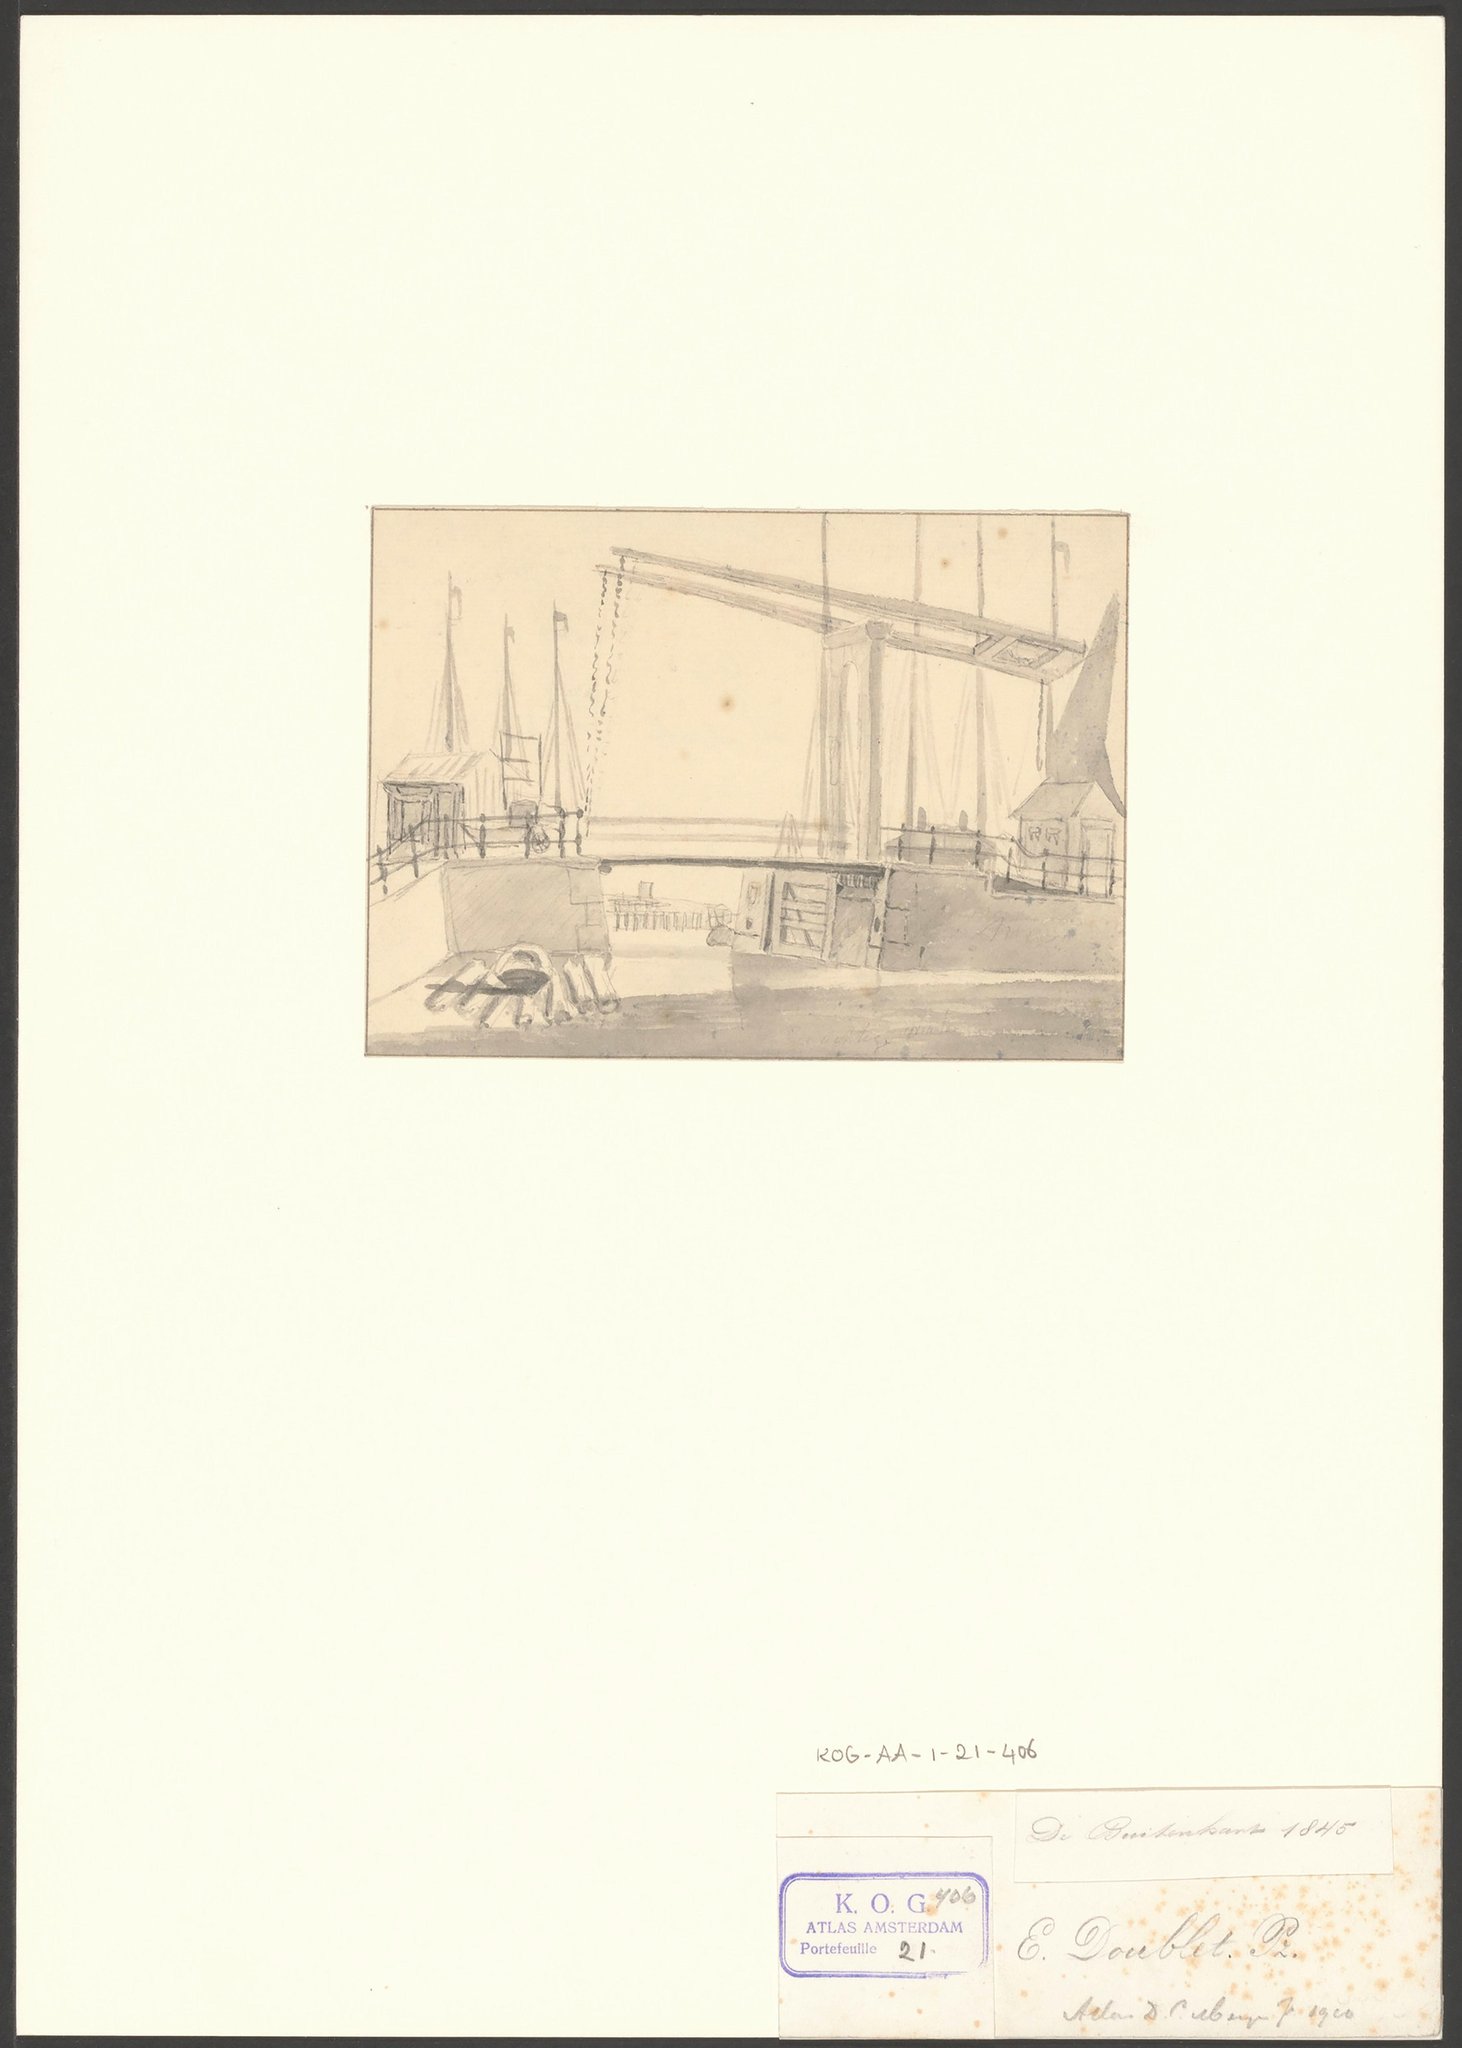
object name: drawing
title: Gezicht op een brug over de Buitenkant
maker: evert doublet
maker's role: draughtsman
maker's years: 1802-1859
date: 1845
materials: ink, paper, pencil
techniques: brush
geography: amsterdam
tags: city-view in general; 'veduta', river, bridge in city across river, canal, etc.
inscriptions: inscription: ‘Port. 21-406’, collector's mark: ‘21’ Lugt 1641b, inscription: ‘De Buitenkant 1845 / E. Doublet. Pz. / Atlas D.C. Meyer Jr 1910’, inscription: ‘Geldersche kade / aan het IJ’